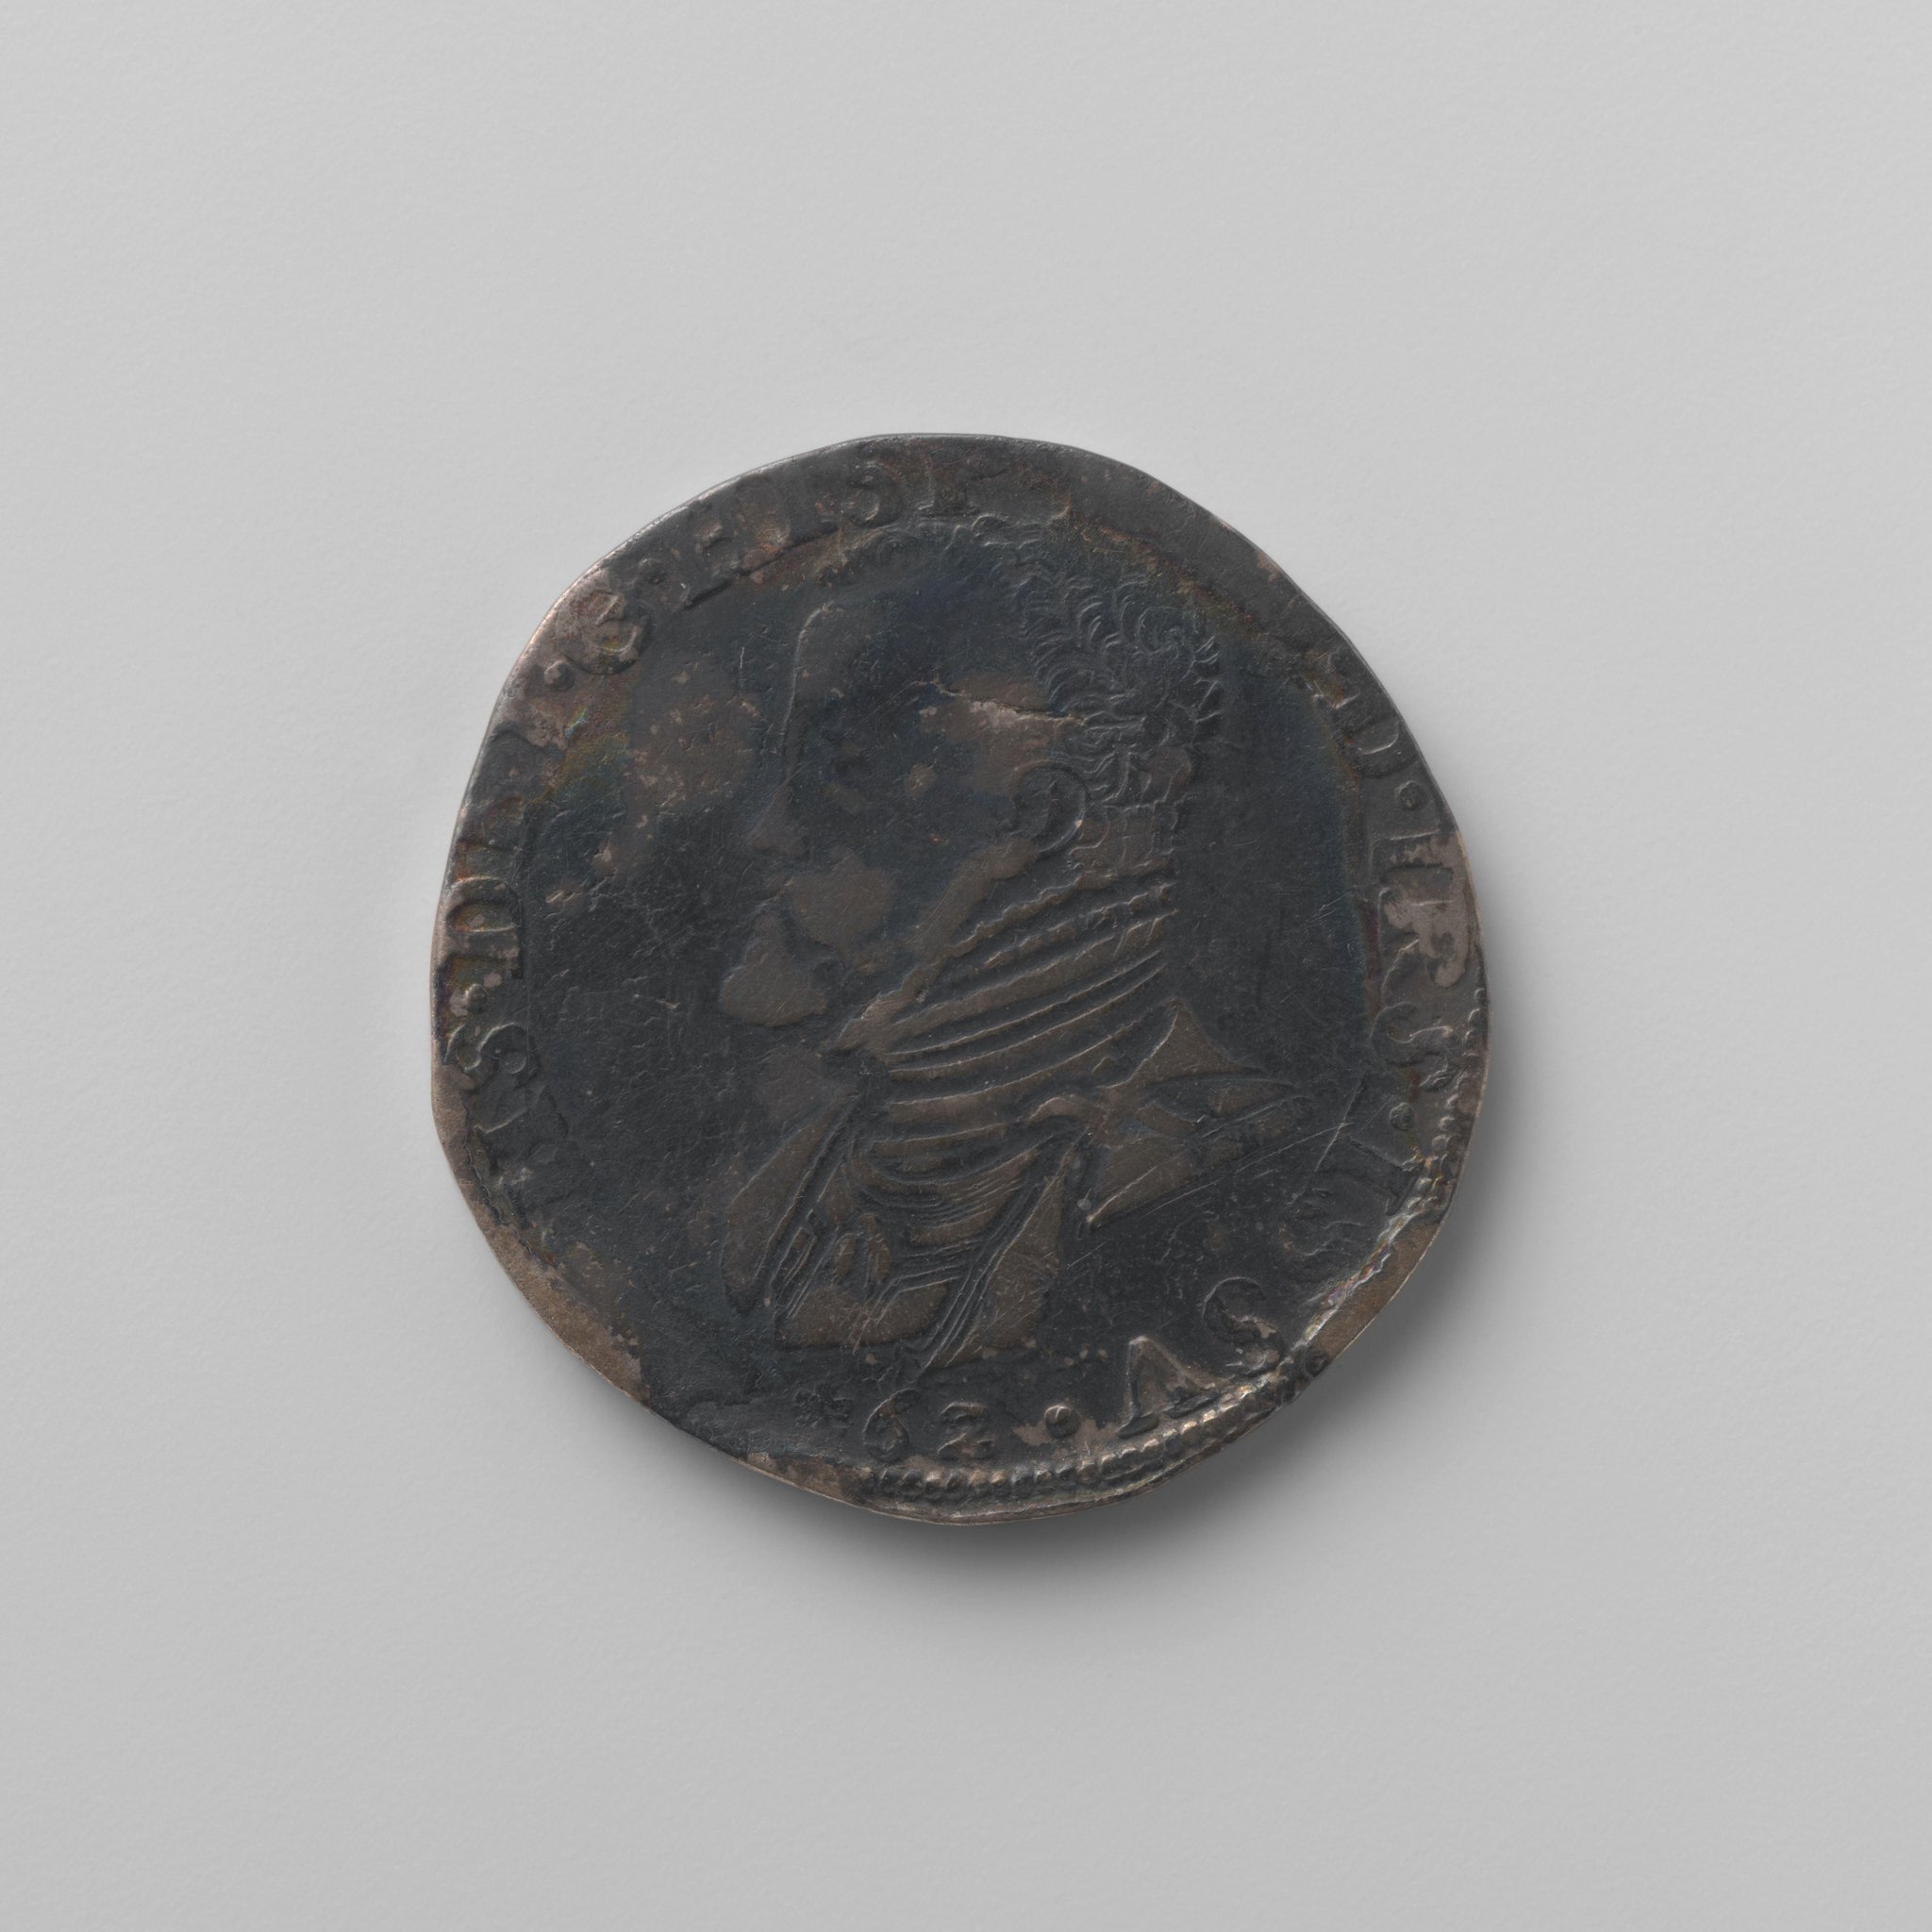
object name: coin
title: Overijsselse ½ philipsdaalder van Philips II, 1562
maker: philip ii of spain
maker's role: koning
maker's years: 1527-1598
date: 1562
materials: silver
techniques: striking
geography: hasselt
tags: philip ii of spain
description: Zilveren munt. Voorzijde: tussen twee vuurstenen gekroond Spaans-Bourgondisch wapenschild op stokkenkruis. Keerzijde: portret Philips II naar links, daaronder jaartal.